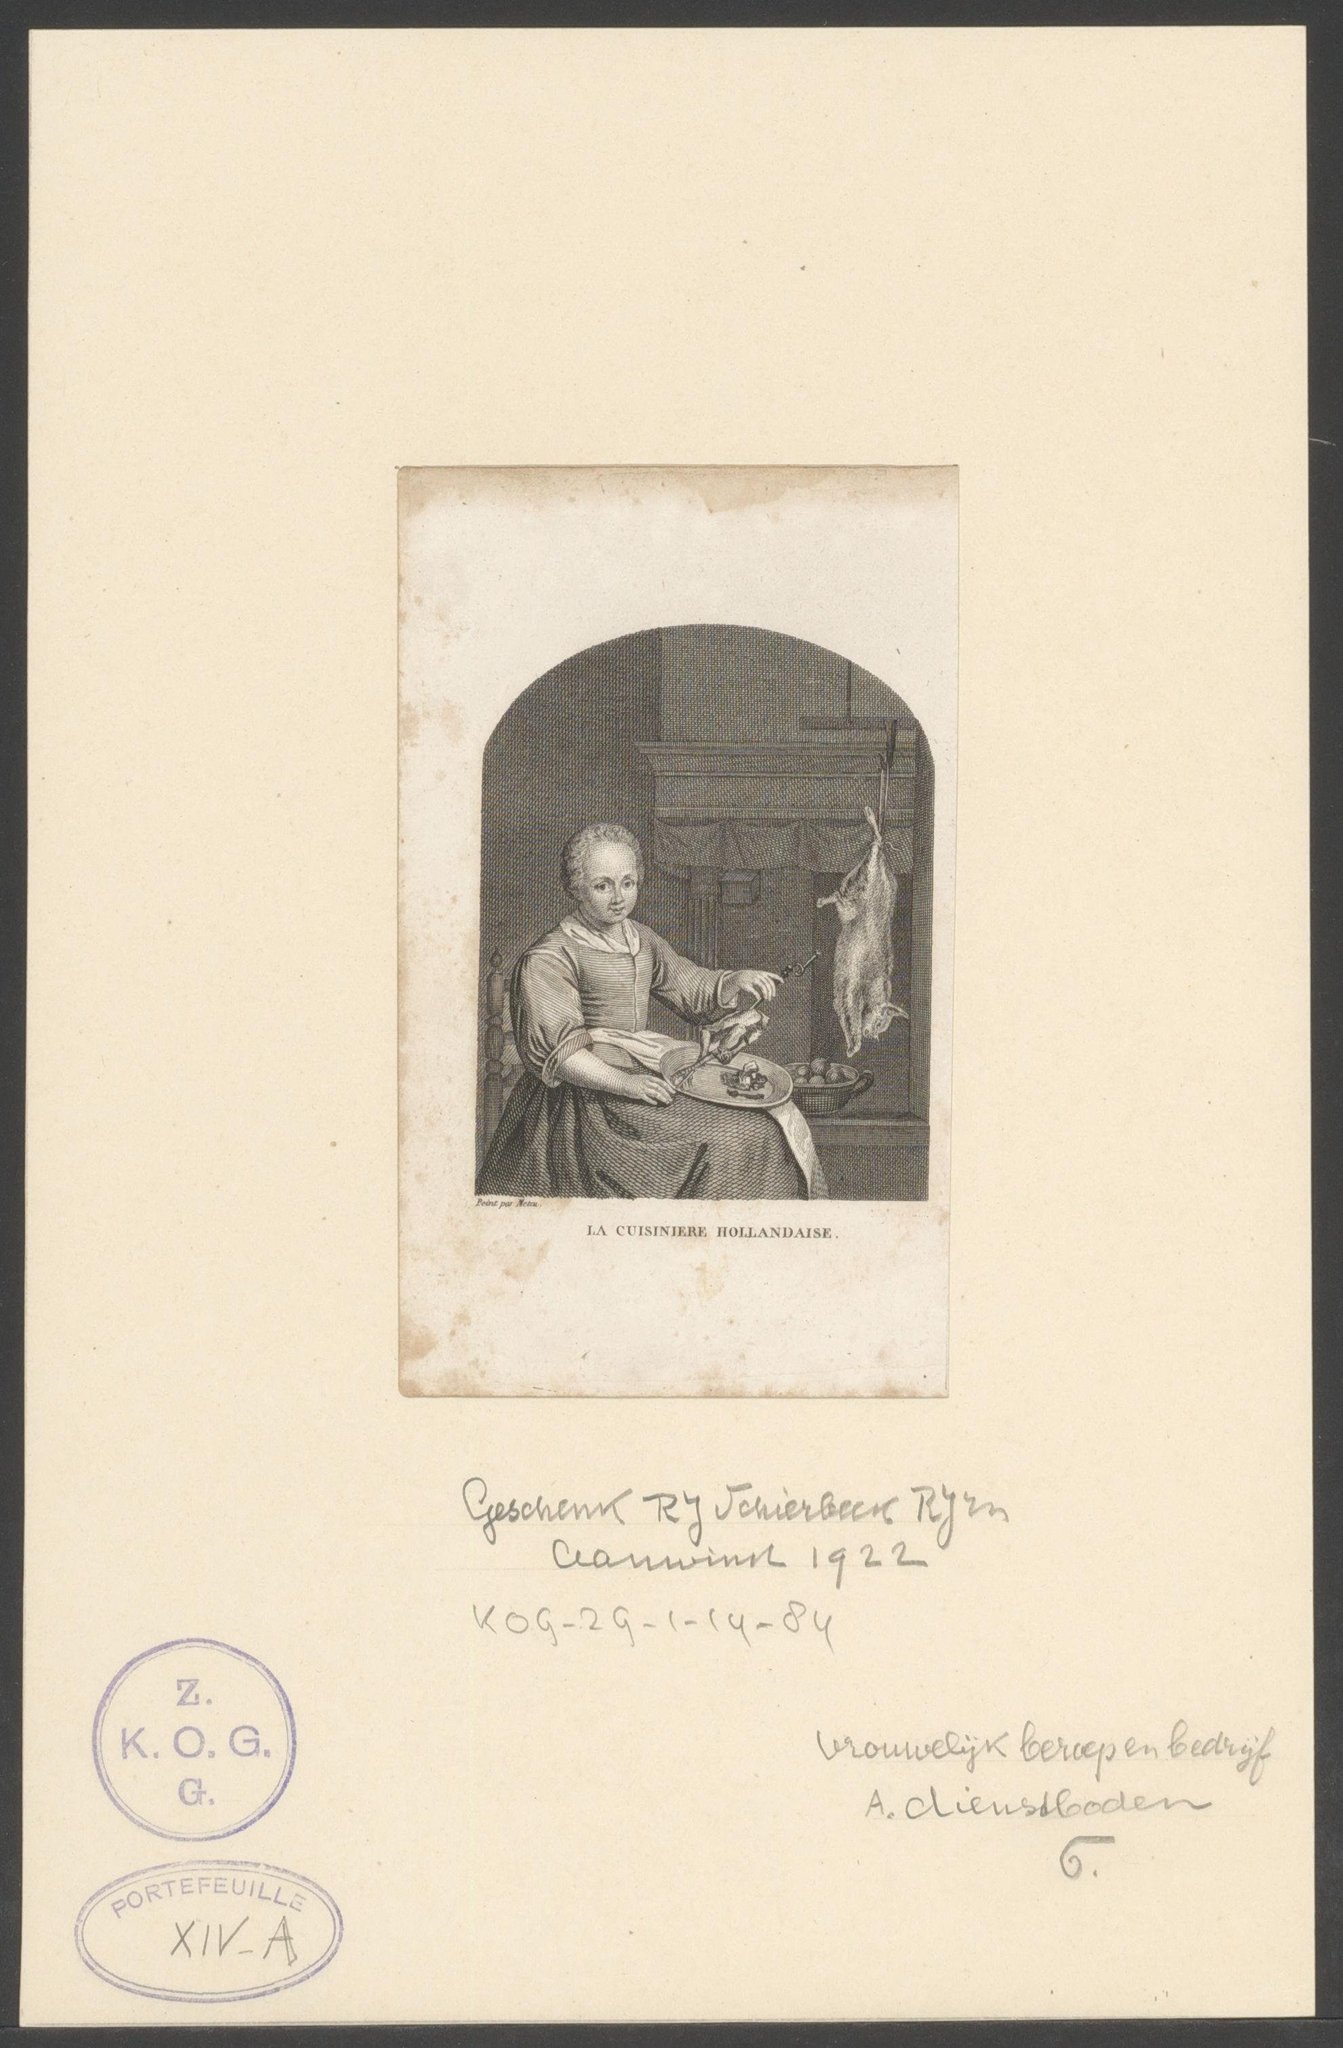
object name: print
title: De Hollandse kokkin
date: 1800-1899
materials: paper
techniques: engraving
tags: kitchen, kitchen-maid, kitchen servant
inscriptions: collector's mark, collector's mark: Lugt 1641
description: Een kokkin zittend naast een schouw. Zij houdt een spies met een gebraden haan in haar hand. Naast de schouw hangt een konijn aan zijn achterpoot. Onderwerpsrubrieken binnen de Atlas Zeden en Gewoonten: Beroep en bedrijf. Vrouwelijk beroep en bedrijf. Dienstboden.